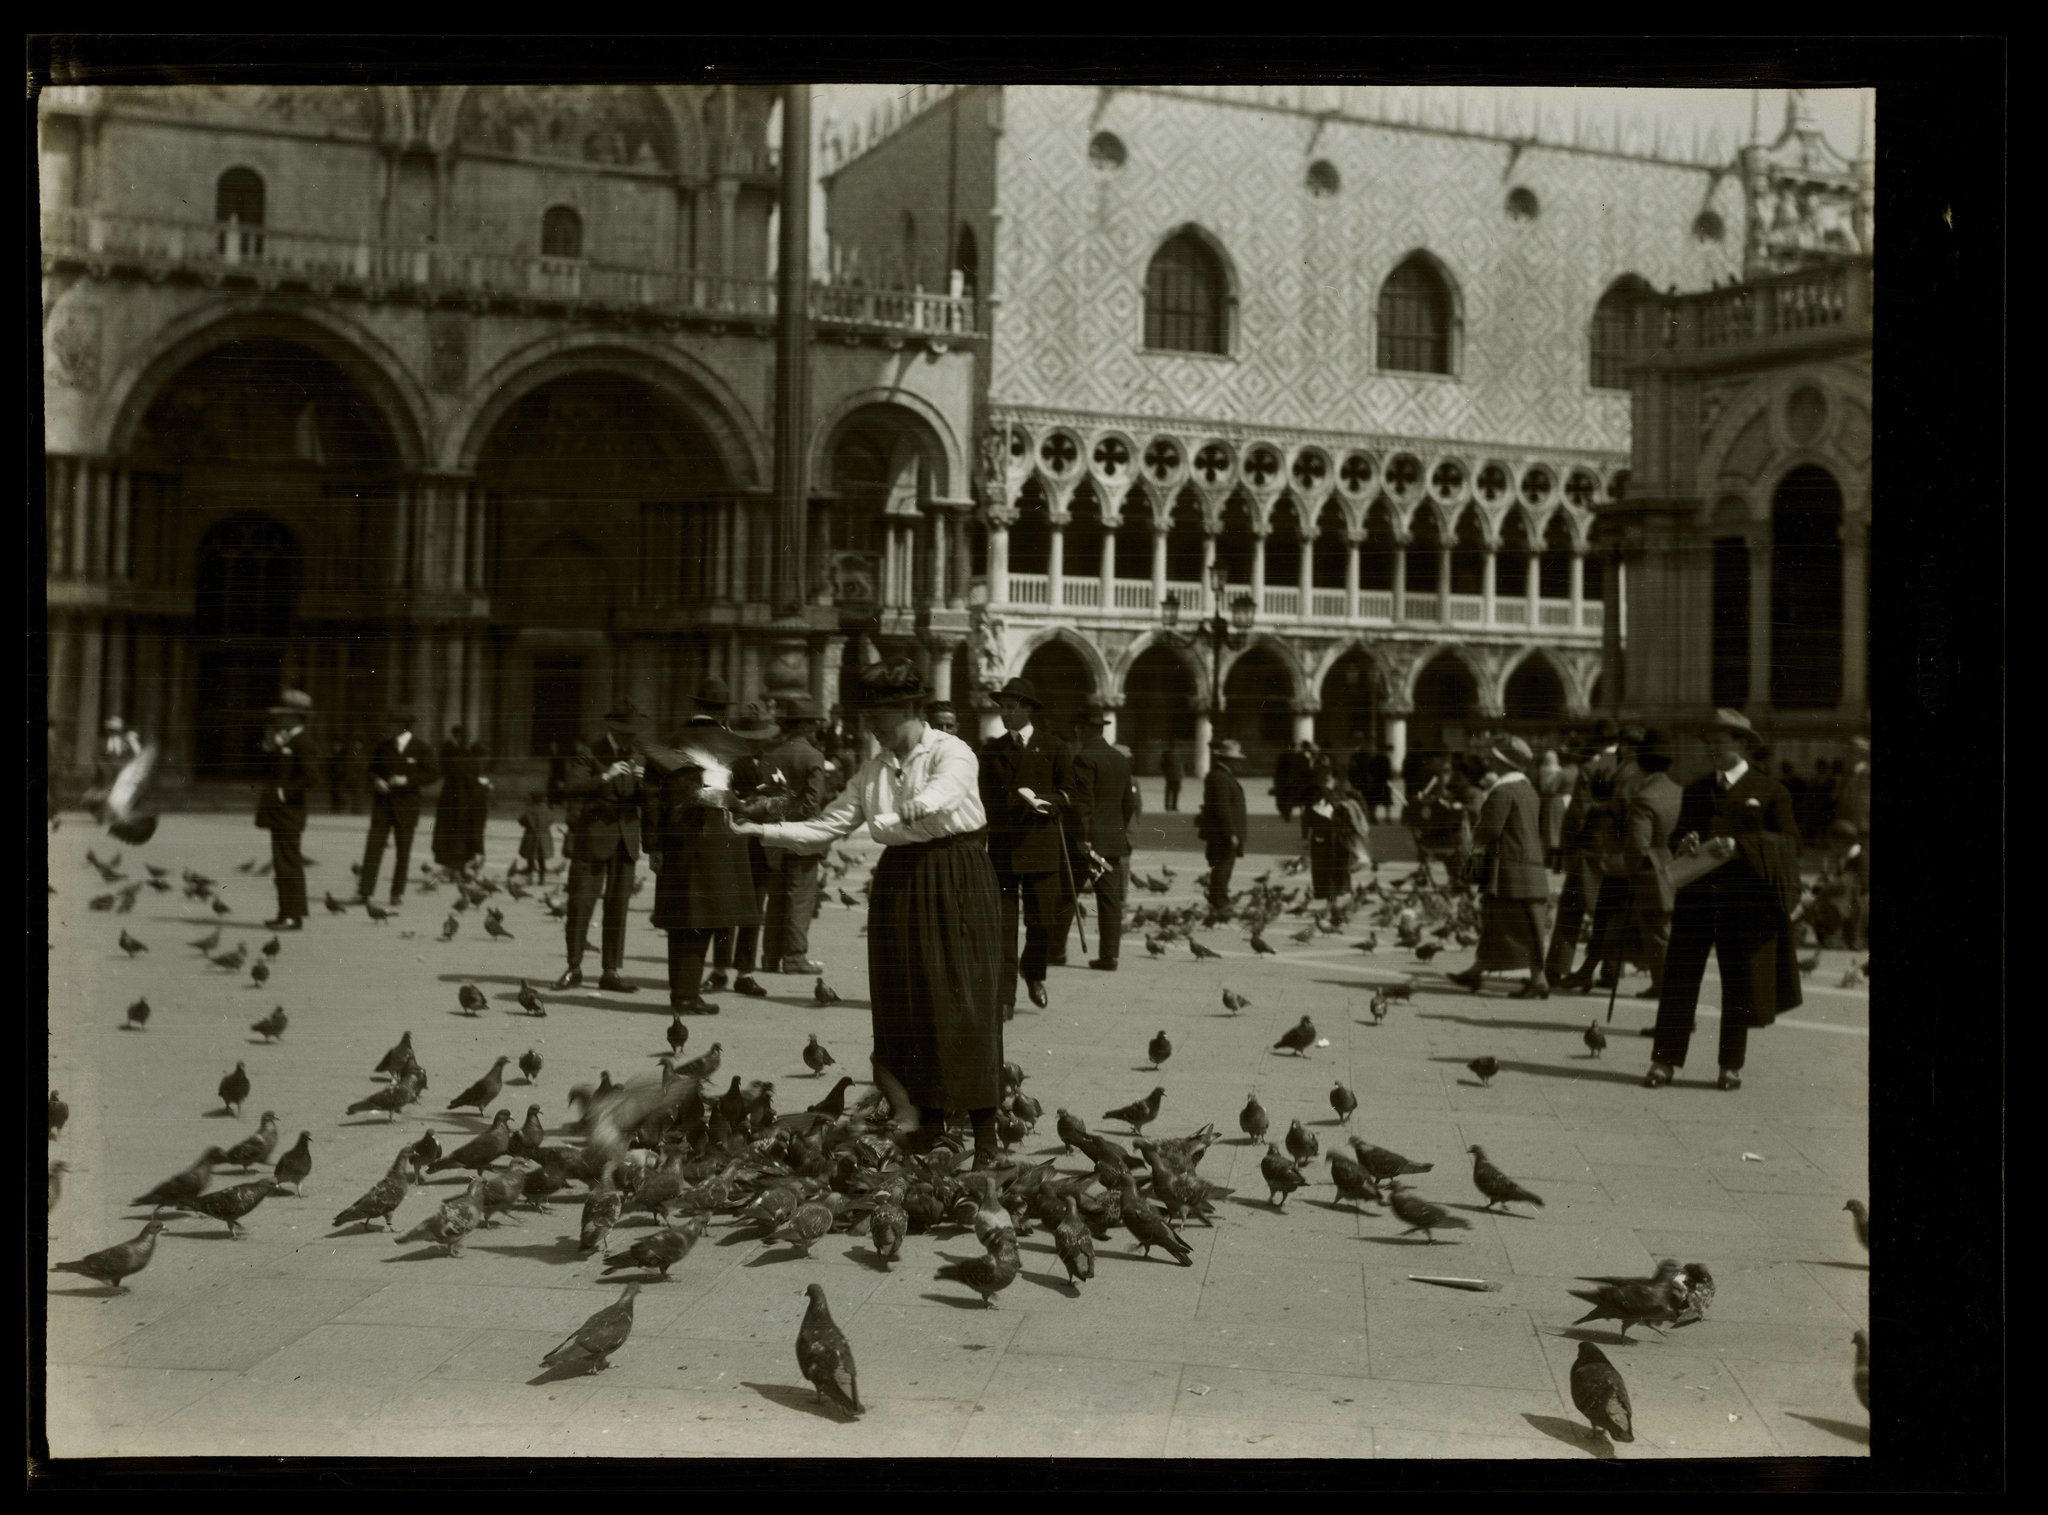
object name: negative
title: Filmnegatief met opname van Venetië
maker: Anonymous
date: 1907-1935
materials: film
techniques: gelatin silver negative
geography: venice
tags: venice